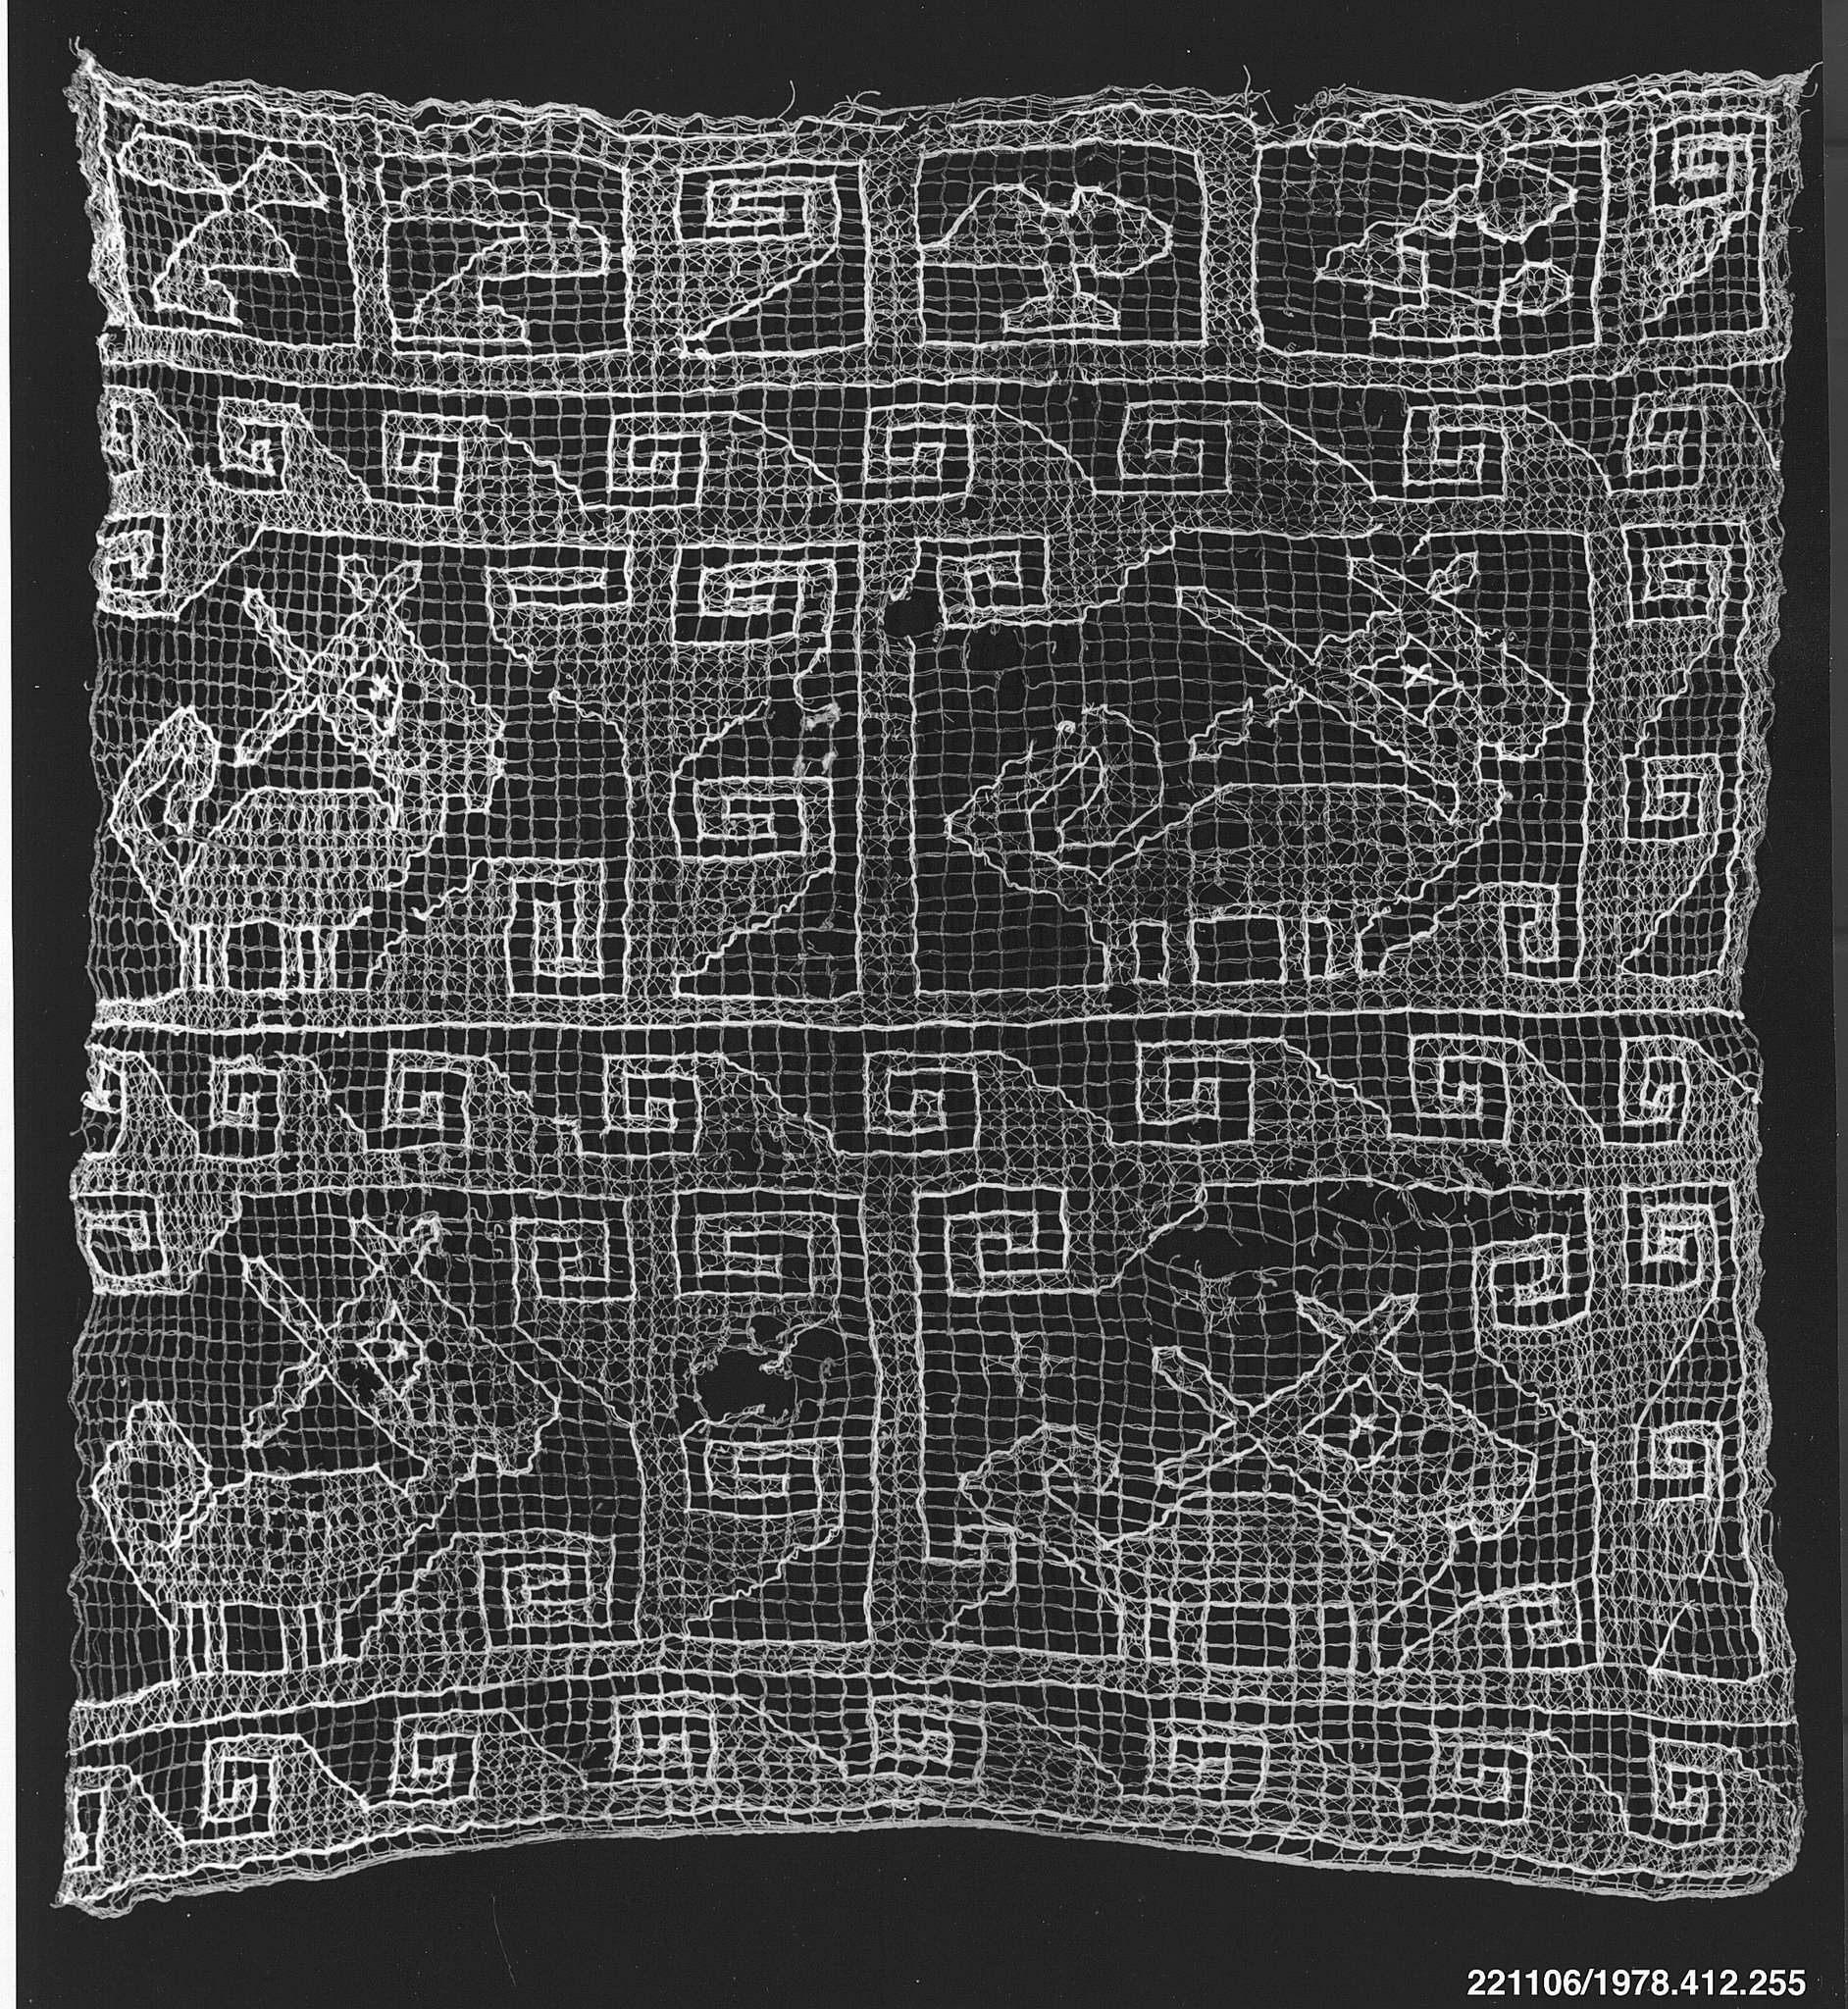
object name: headband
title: Openwork Headband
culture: chancay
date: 901-1400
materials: cotton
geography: peru